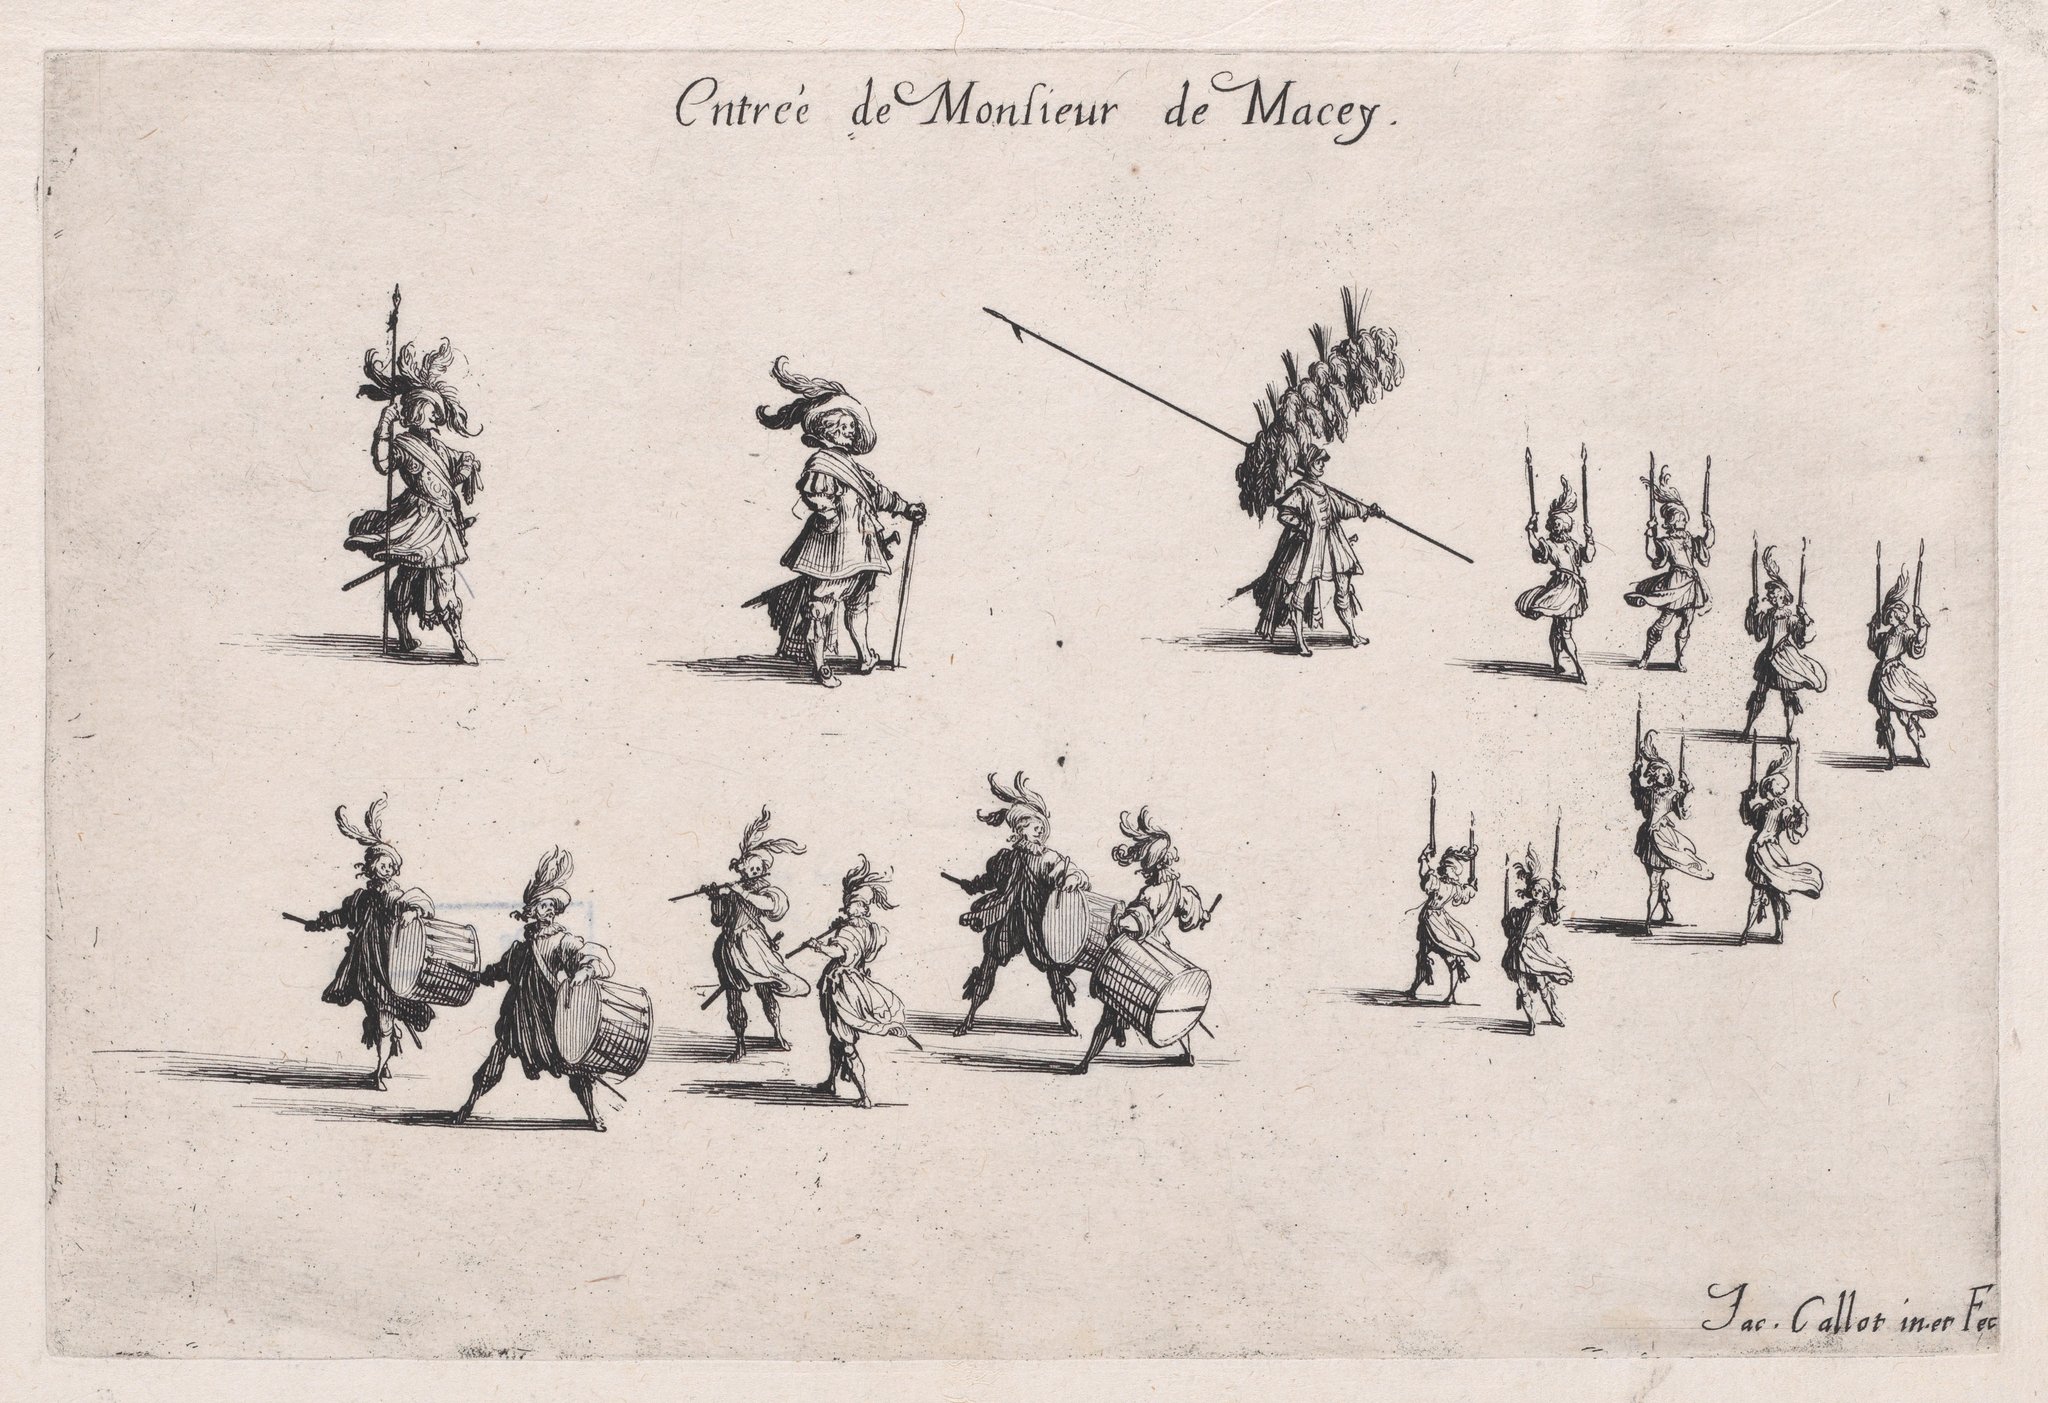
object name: print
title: Entrée de M. de Macey (Entrance of Monsieur de Macey), from "Le Combat a la Barrière"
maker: jacques callot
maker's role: artist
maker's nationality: french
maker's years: 1592-1635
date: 1627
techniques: etching